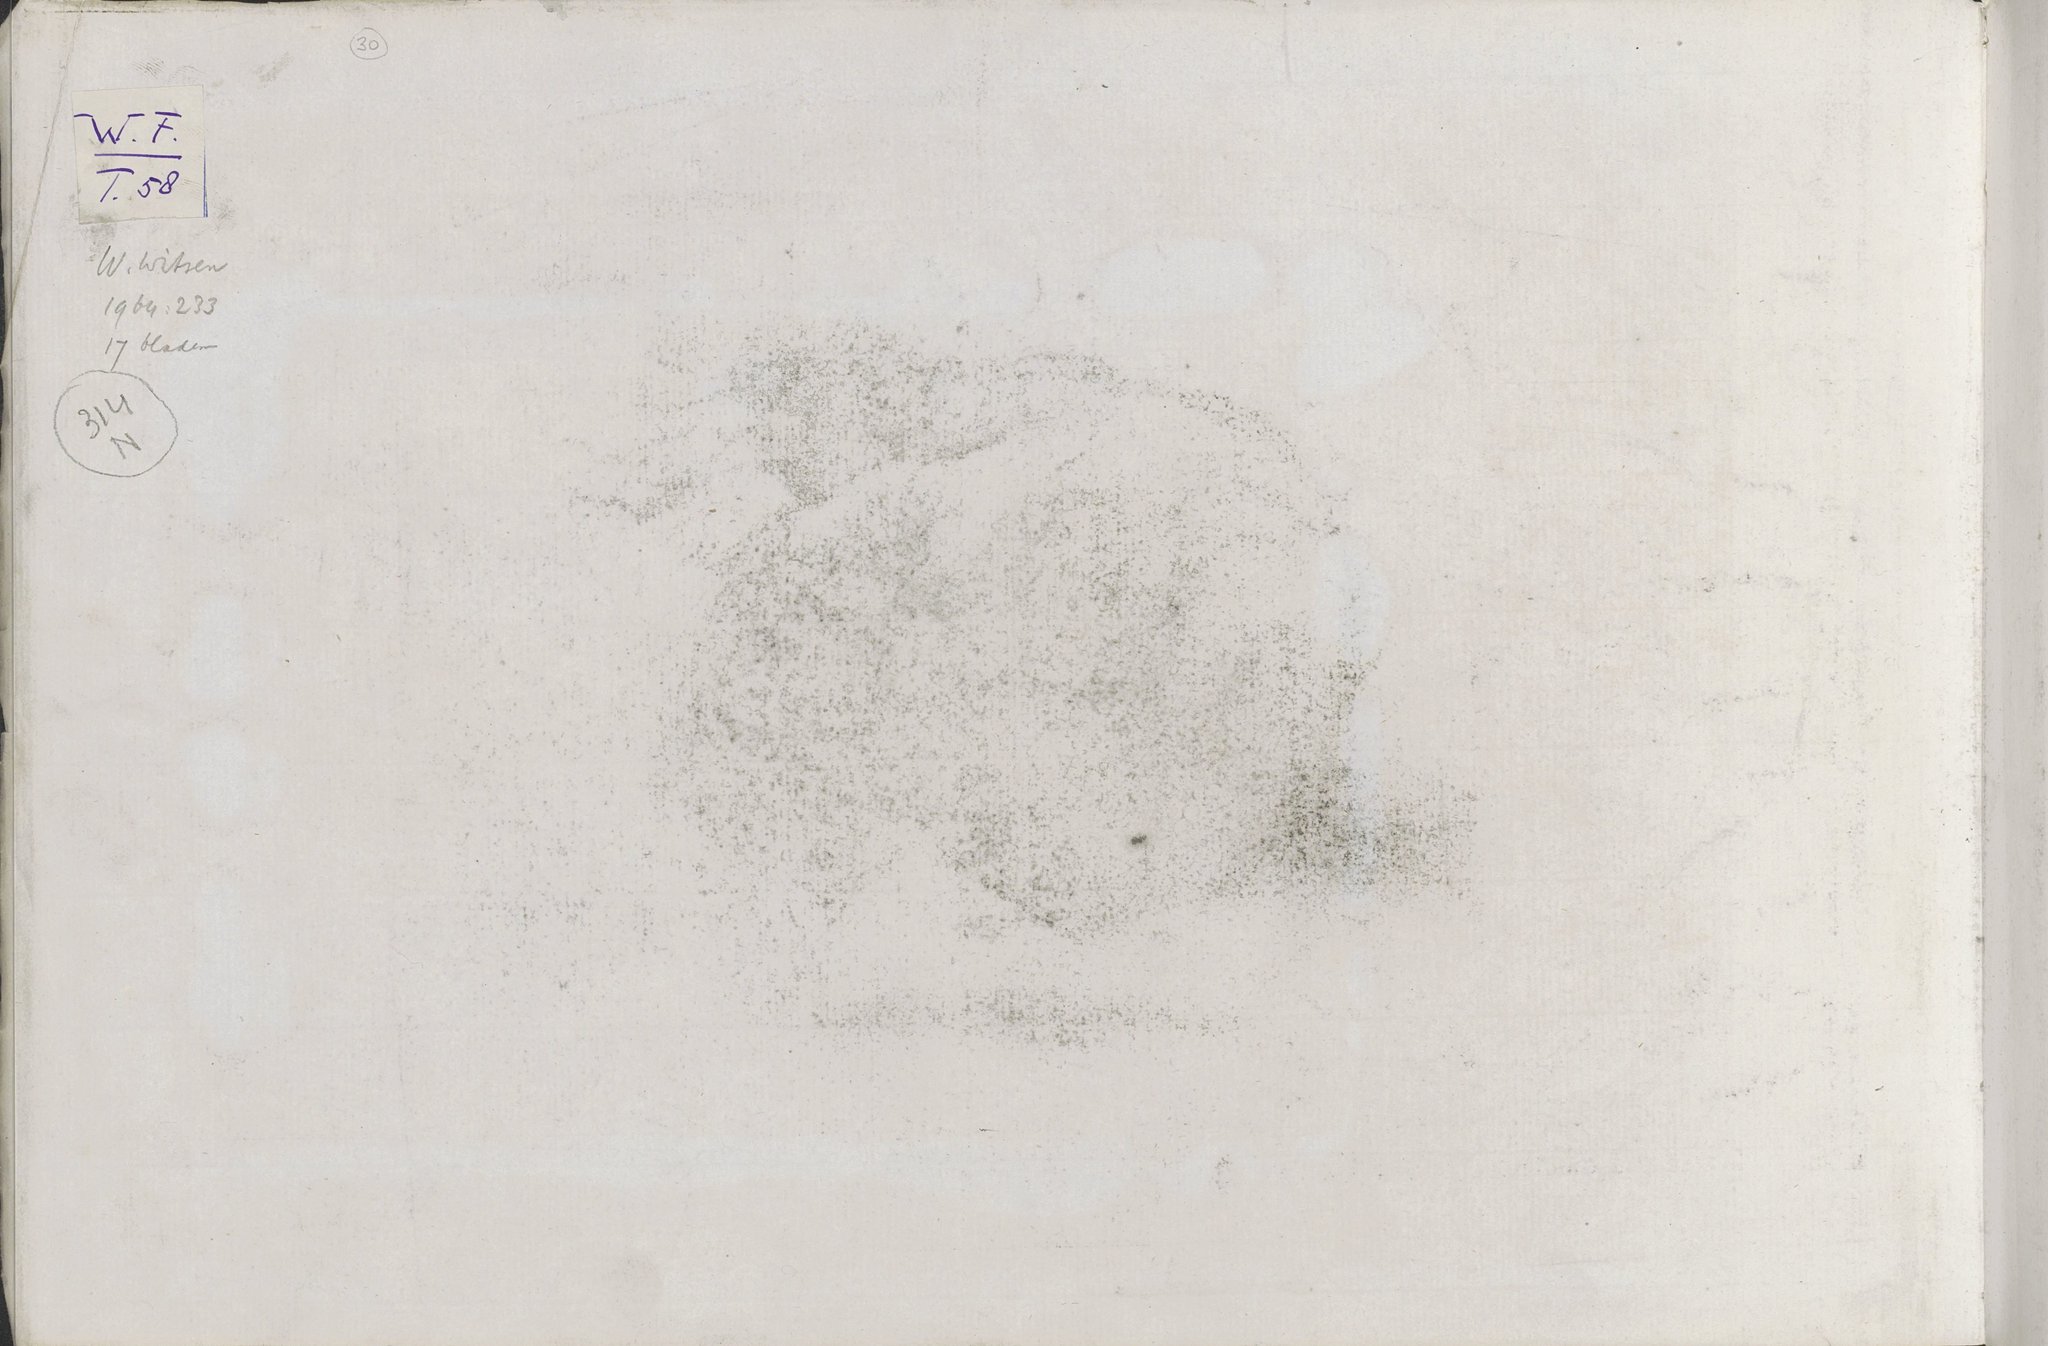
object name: sketchbook leaf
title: Annotaties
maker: willem witsen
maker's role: draughtsman, painter, print maker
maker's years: 1860-1923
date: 1887-1892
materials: paper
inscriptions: annotation: ‘W.F./ T. 58’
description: Schutblad A, voorste schutblad, uit een schetsboek met 17 bladen.